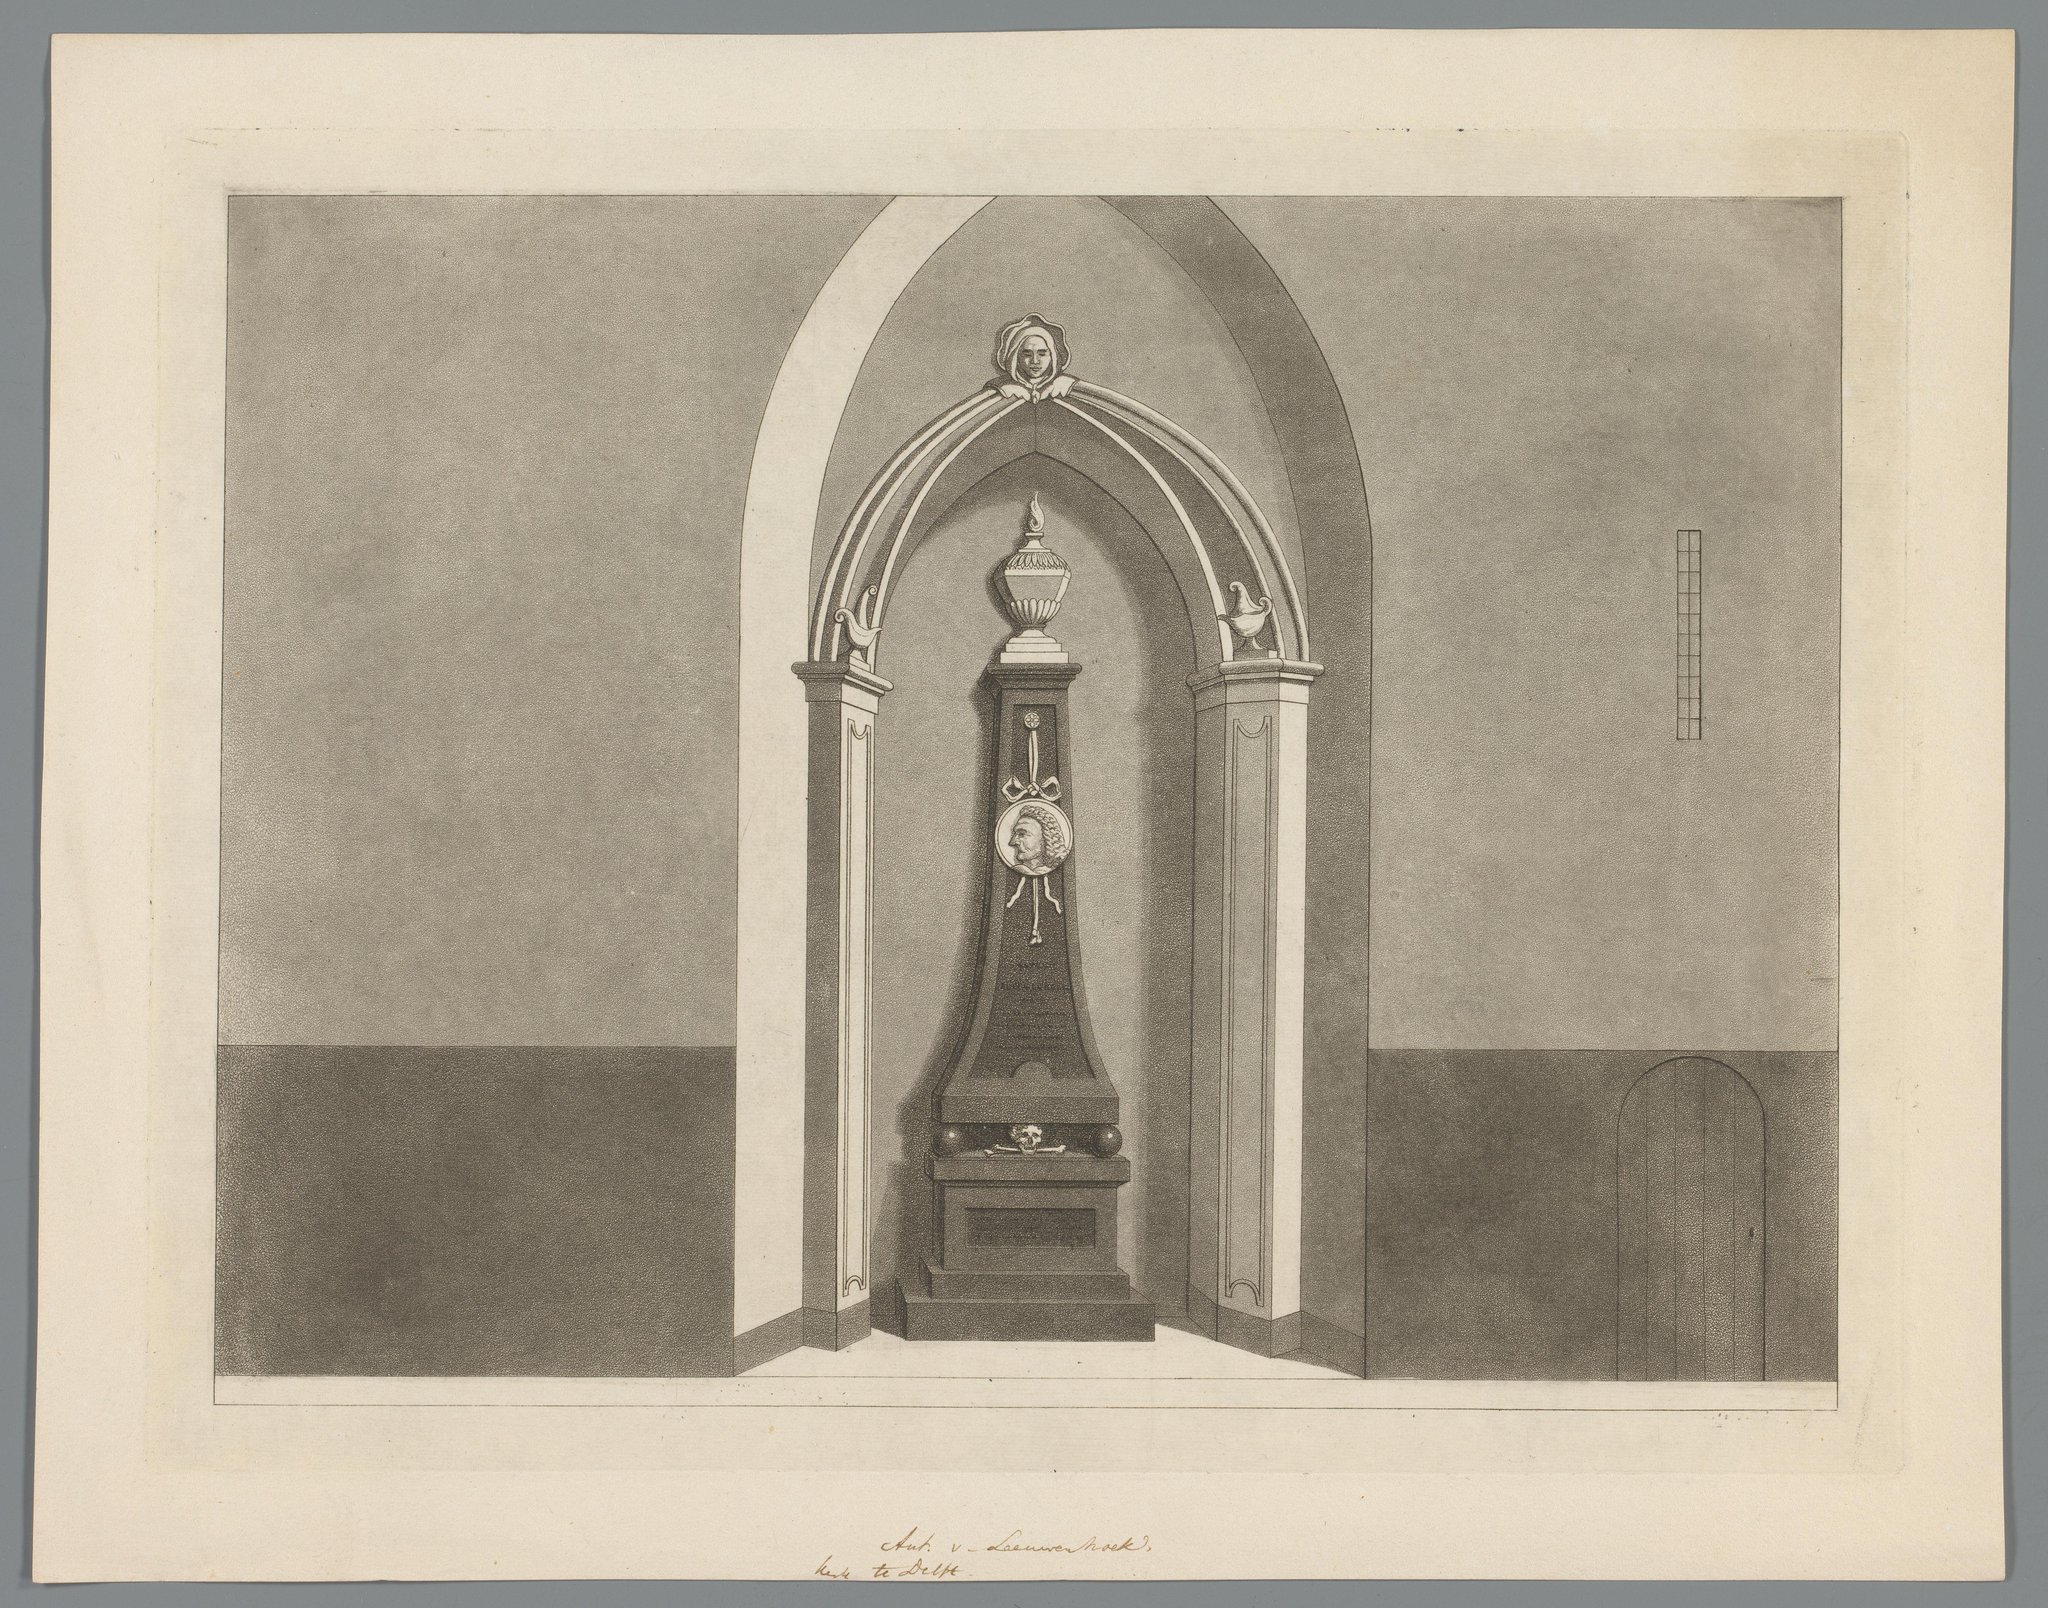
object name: print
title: Grafmonument van Anthony van Leeuwenhoek in de Oude Kerk te Delft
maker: johannes cornelis zürcher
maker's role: print maker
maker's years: 1794-1882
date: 1804-1882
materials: paper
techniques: aquatint, etching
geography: amsterdam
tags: delft, physicist, anthony van leeuwenhoek, grave, tomb and other grave-forms and grave-markers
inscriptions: inscription: ‘Ant. v. Leeuwenhoek./kerk te Delft.’